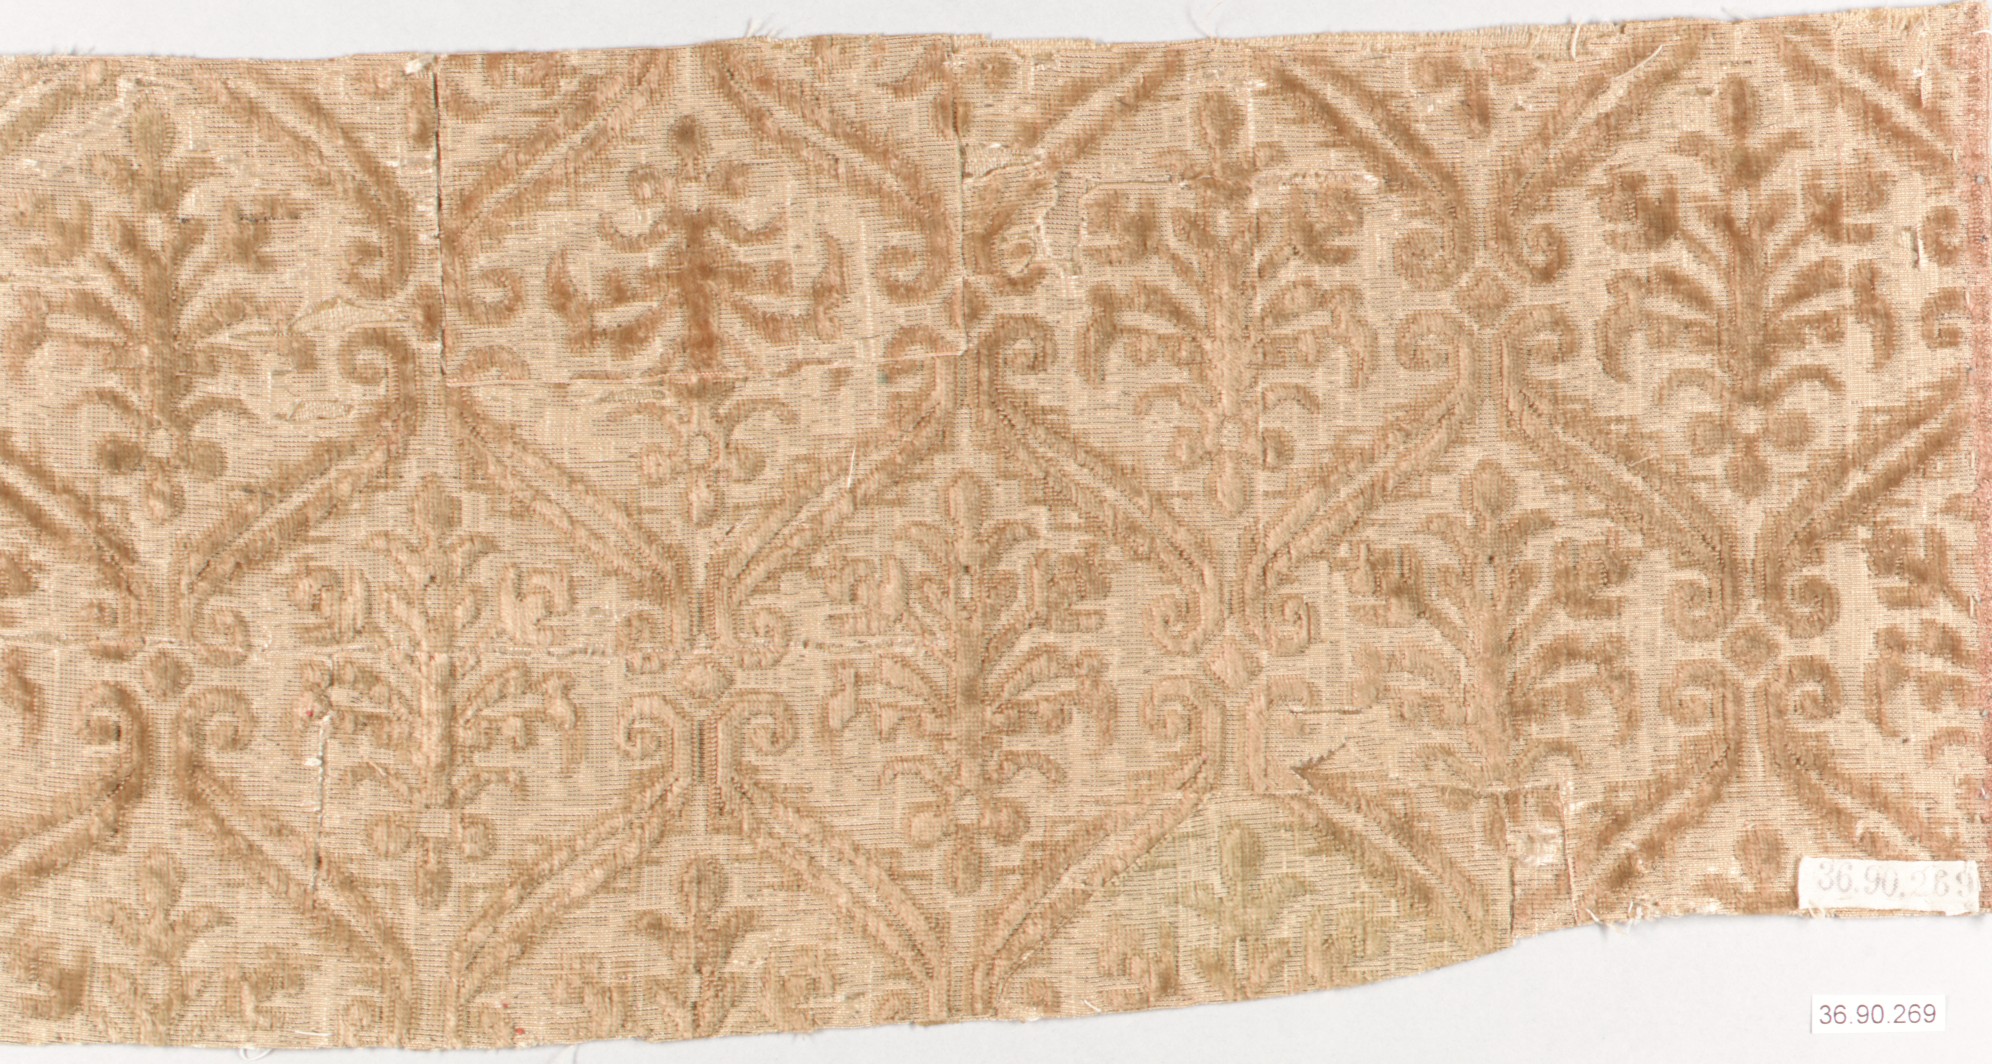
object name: piece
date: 1501-1700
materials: metal thread, silk